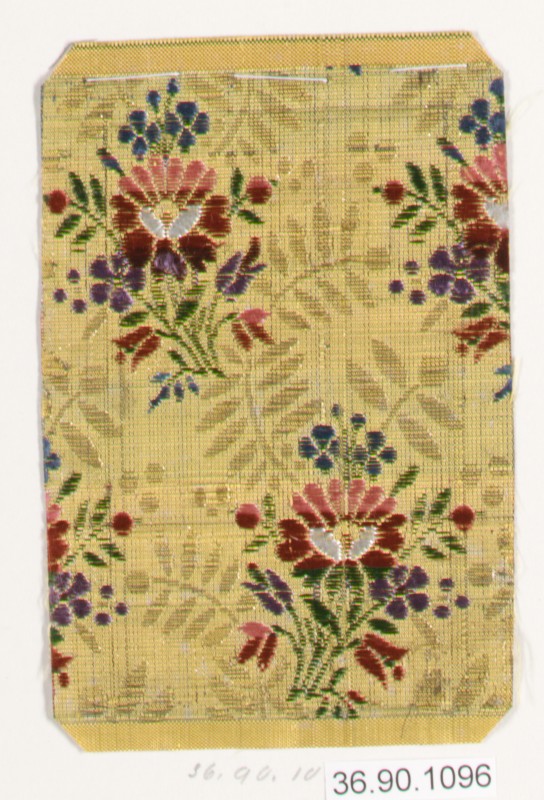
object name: sample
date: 1701-1900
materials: metal thread, silk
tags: flowers,leaves